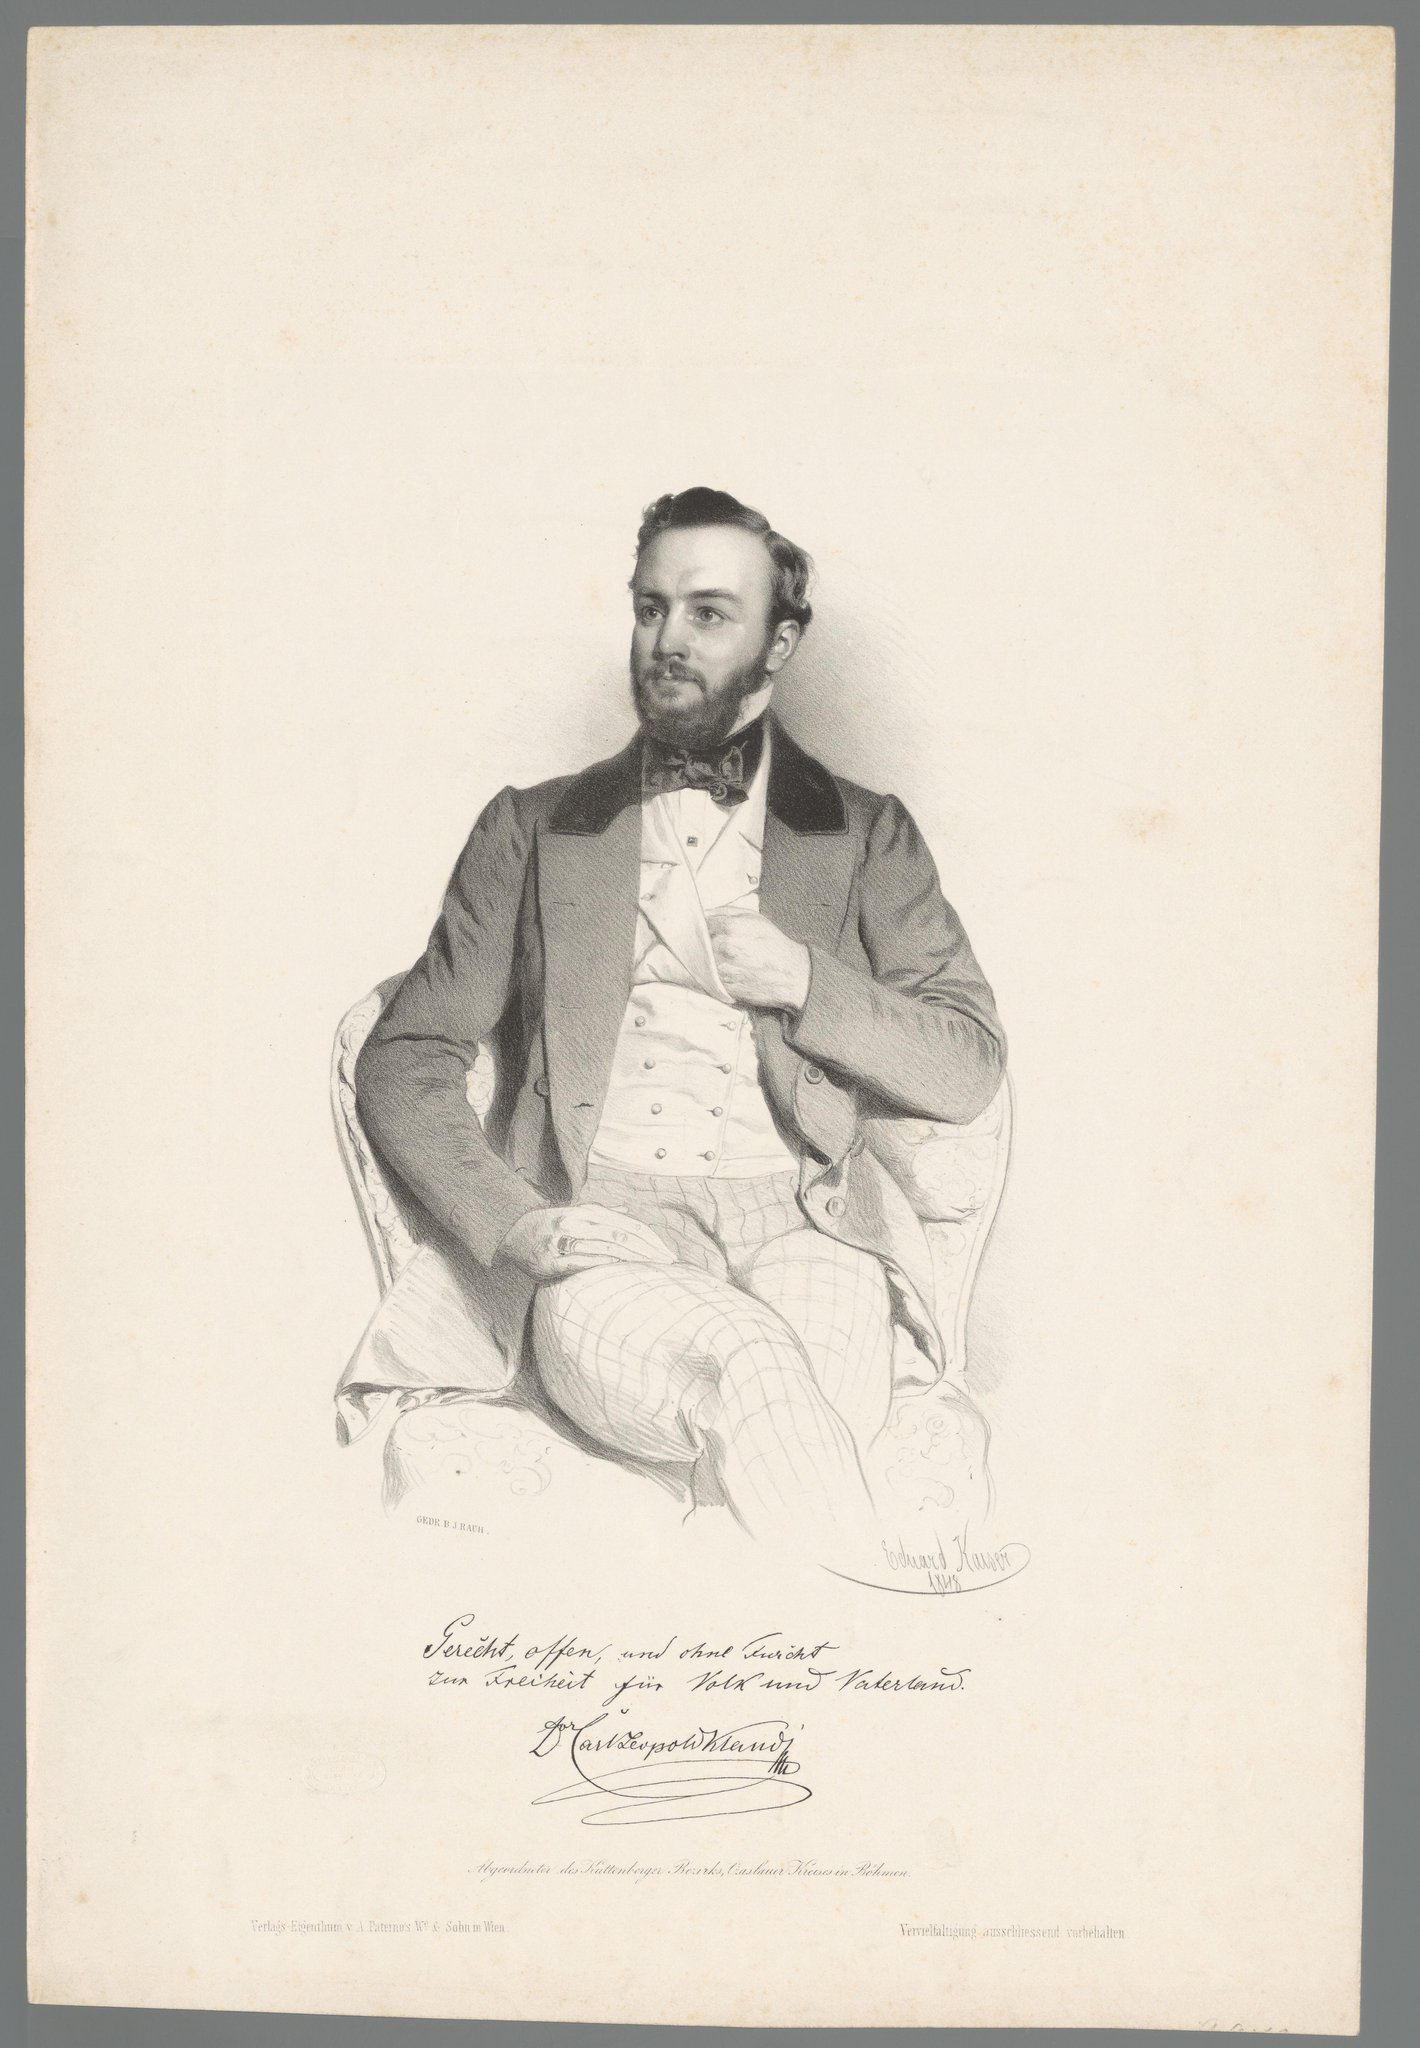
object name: print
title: Portret van Karel Leopold von Klaudy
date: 1848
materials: paper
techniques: lithograph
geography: vienna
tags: adult man, historical persons, beard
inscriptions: collector's mark: Lugt 2228, check stamp: ‘A. Paterno s Wtwe. & Sohn Kunsthandlung in Wien’